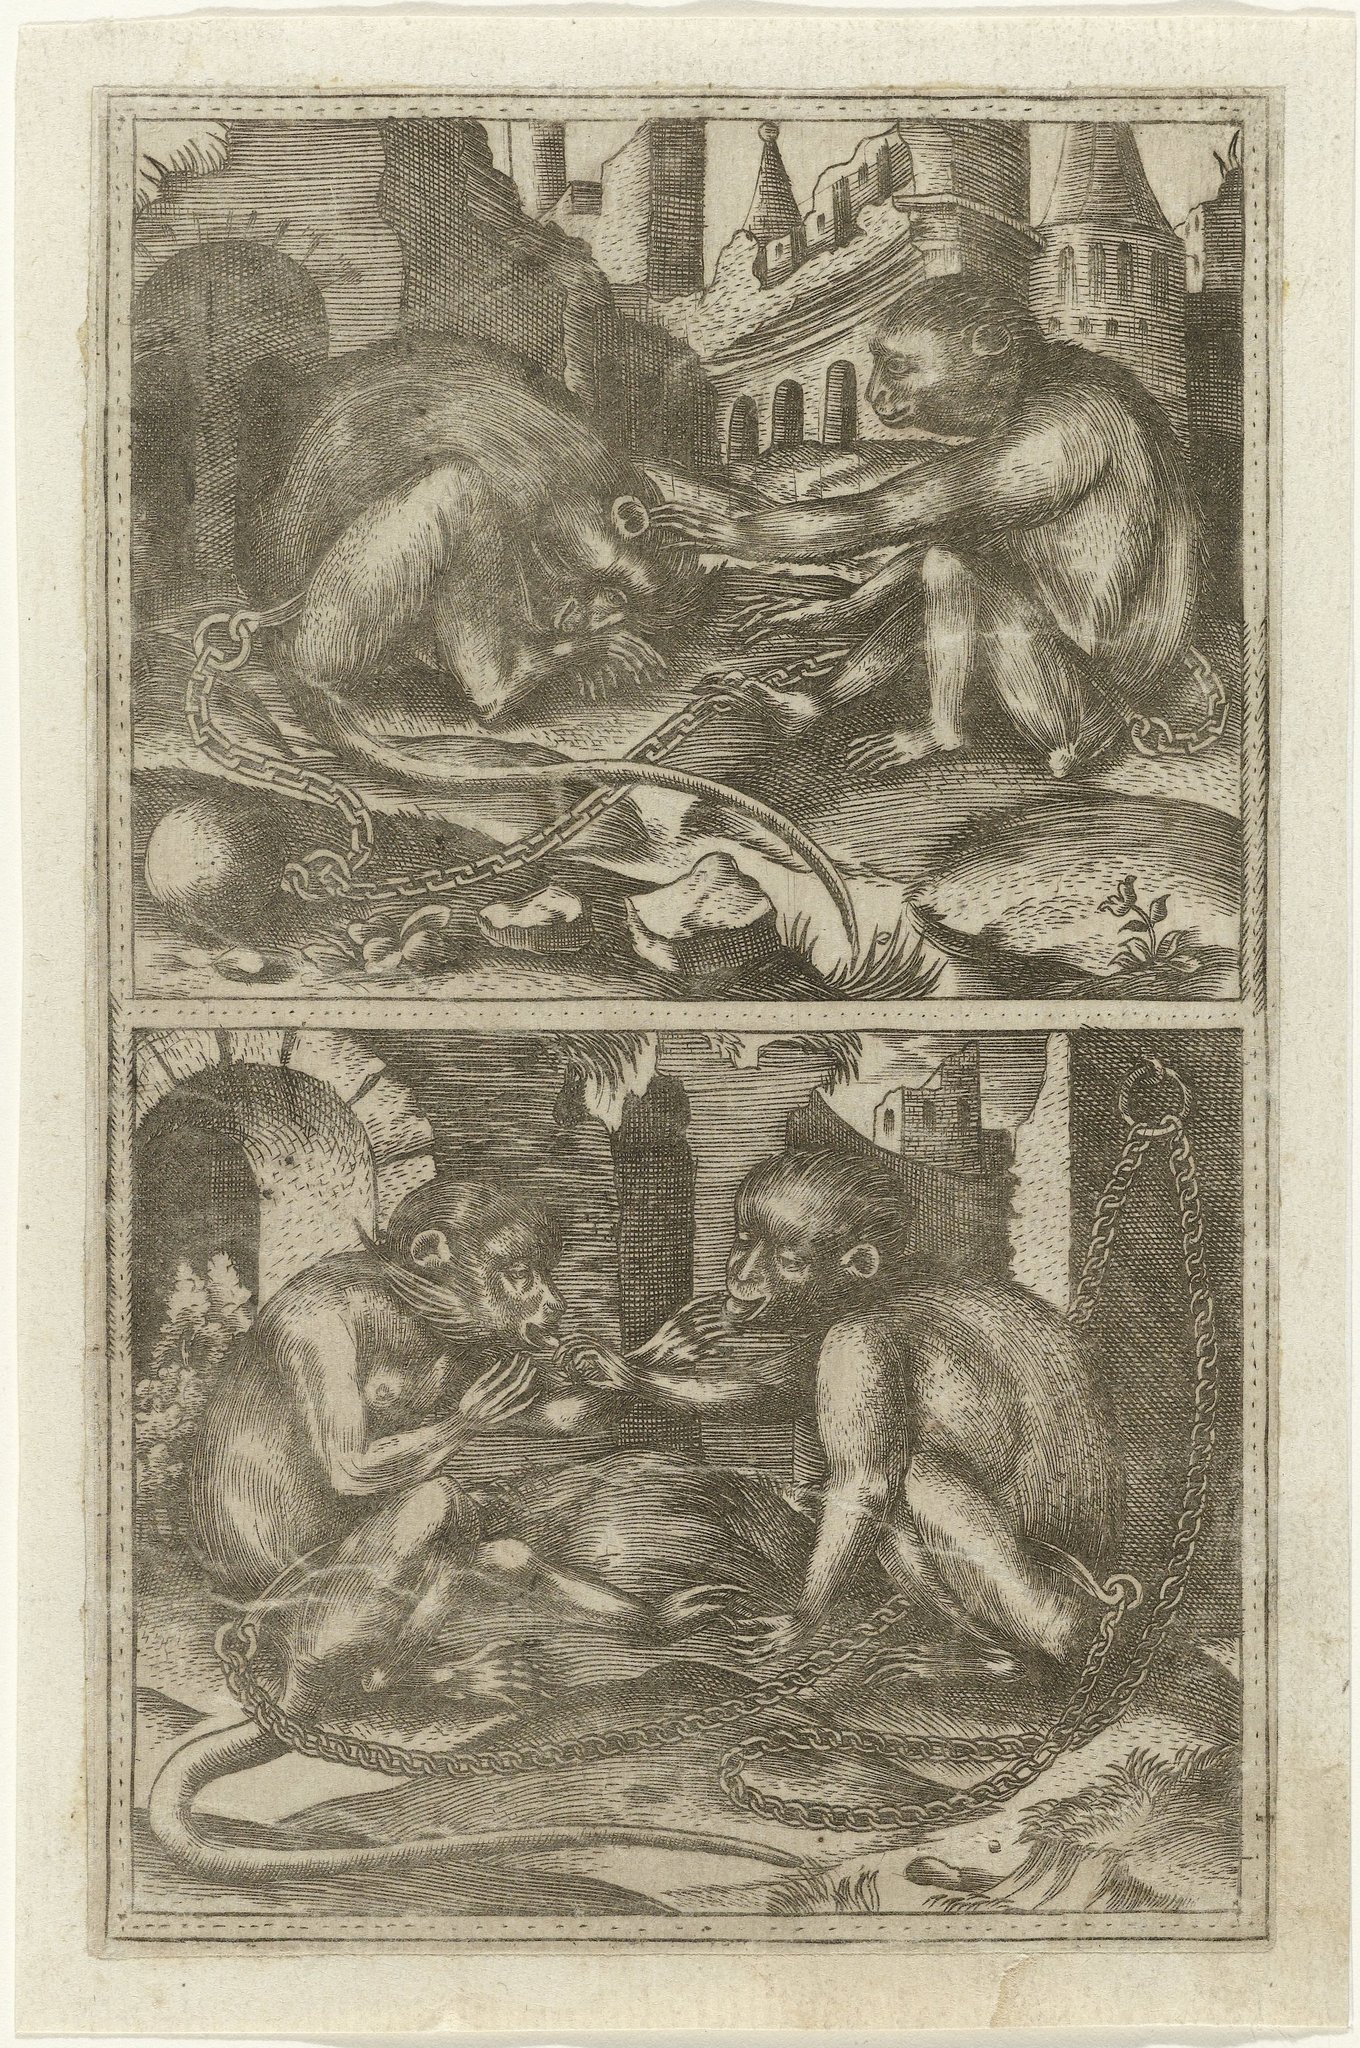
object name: print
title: Twee scènes met ieder twee geketende apen tussen ruïnes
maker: Anonymous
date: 1540-1560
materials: paper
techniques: engraving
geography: france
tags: monkeys, apes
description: Twee scènes met geketende aapjes in twee kaders met op de achtergrond antieke ruïnes. Bij het bovenste paar wordt een liggend aapje met staart links op het hoofd geaaid door een staartloos, zittend aapje rechts. Het onderste paar likt elkaars handen.